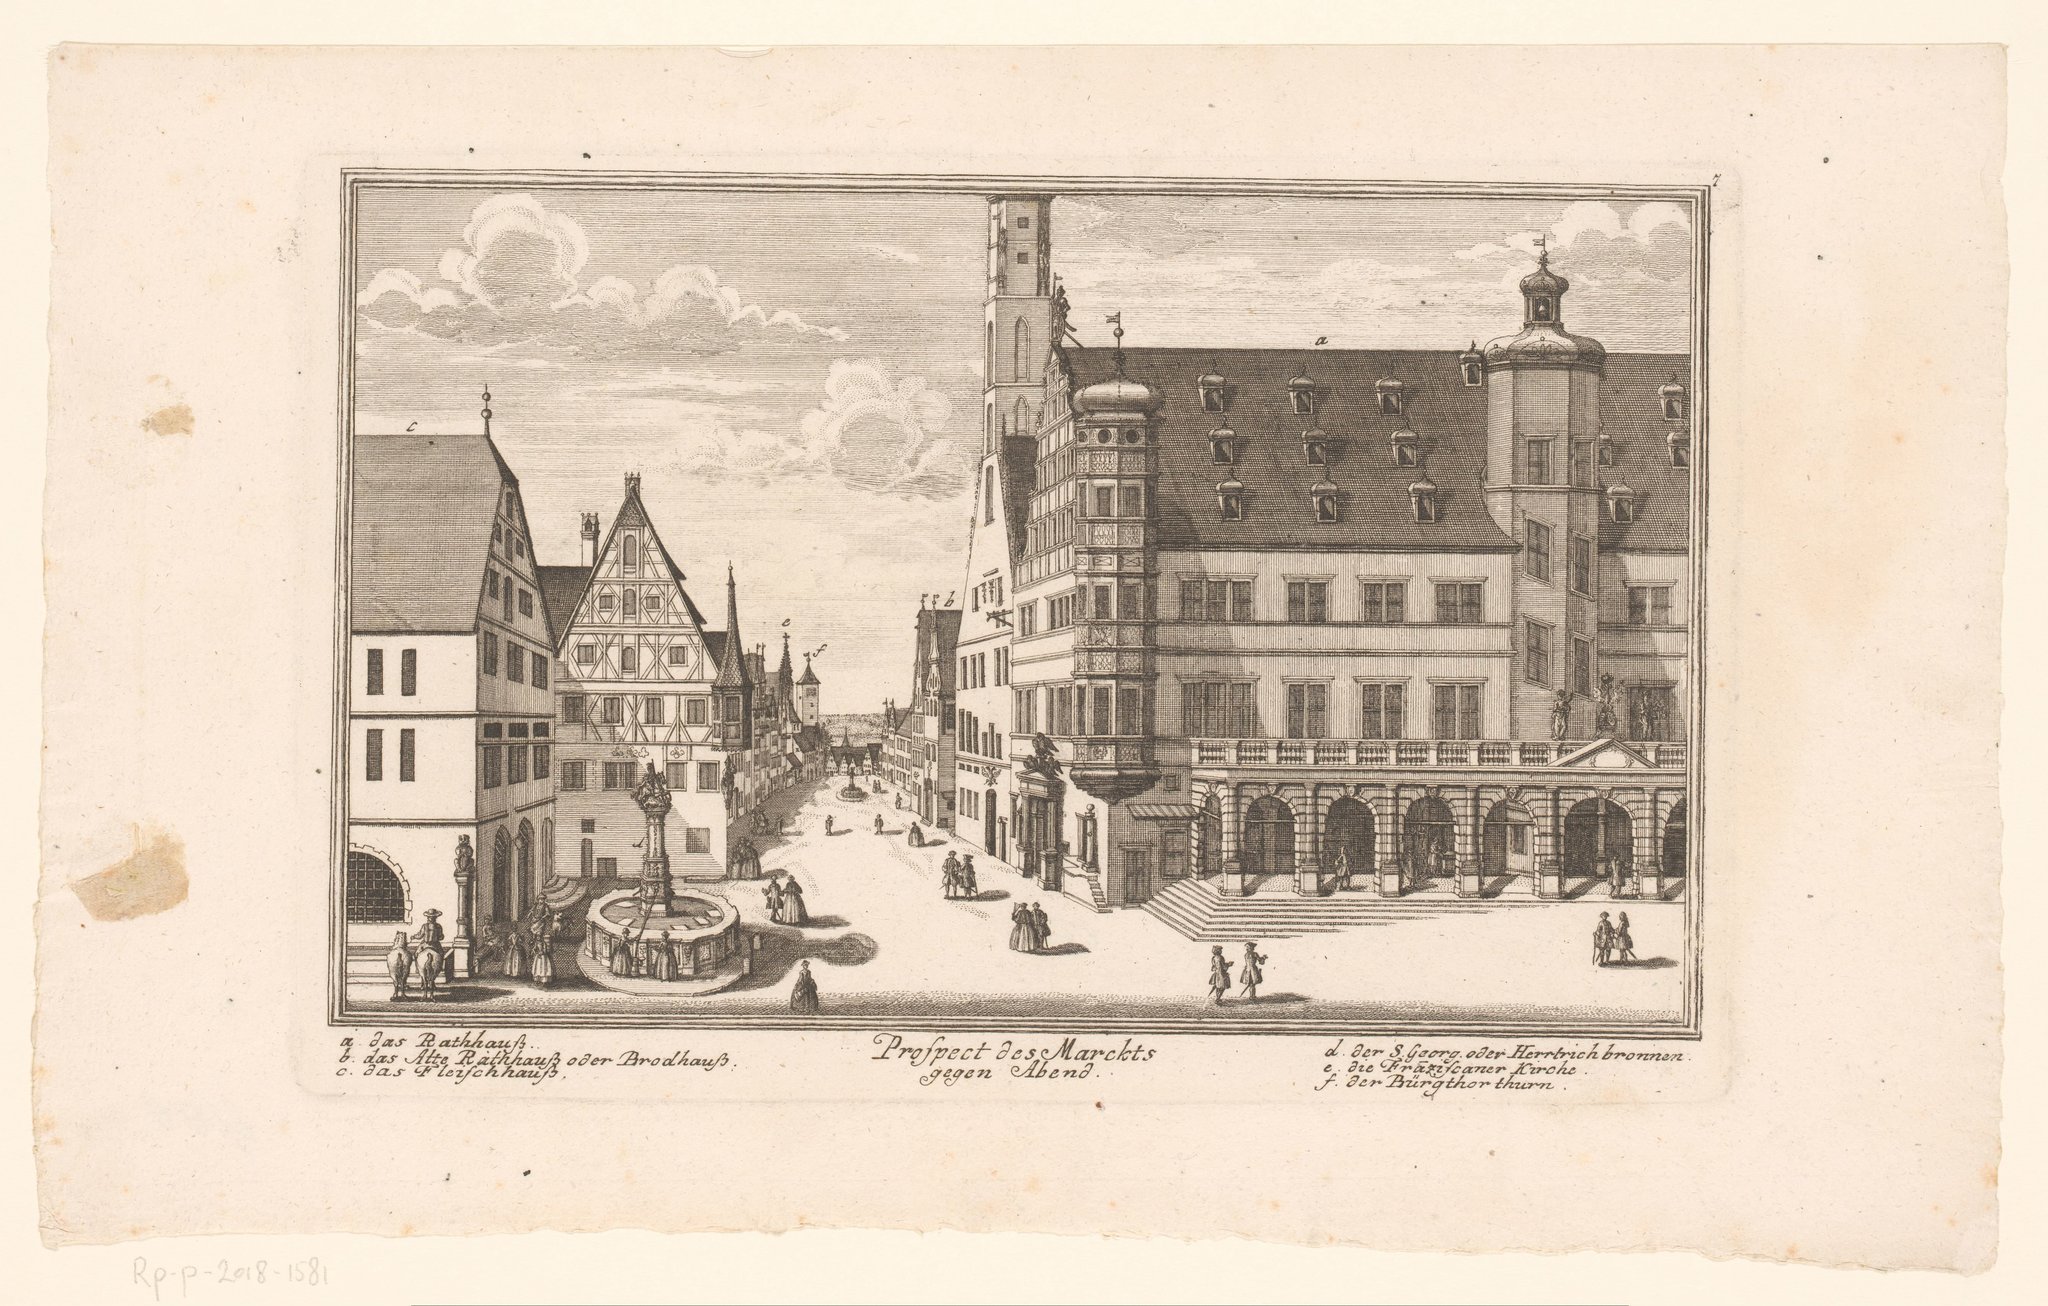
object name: print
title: Gezicht op de Markt en het stadhuis, te Rothenbrug ob der Tauber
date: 1758-1796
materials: paper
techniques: engraving, etching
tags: square, place, circus, etc., townhall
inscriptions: collector's mark: Lugt 2228